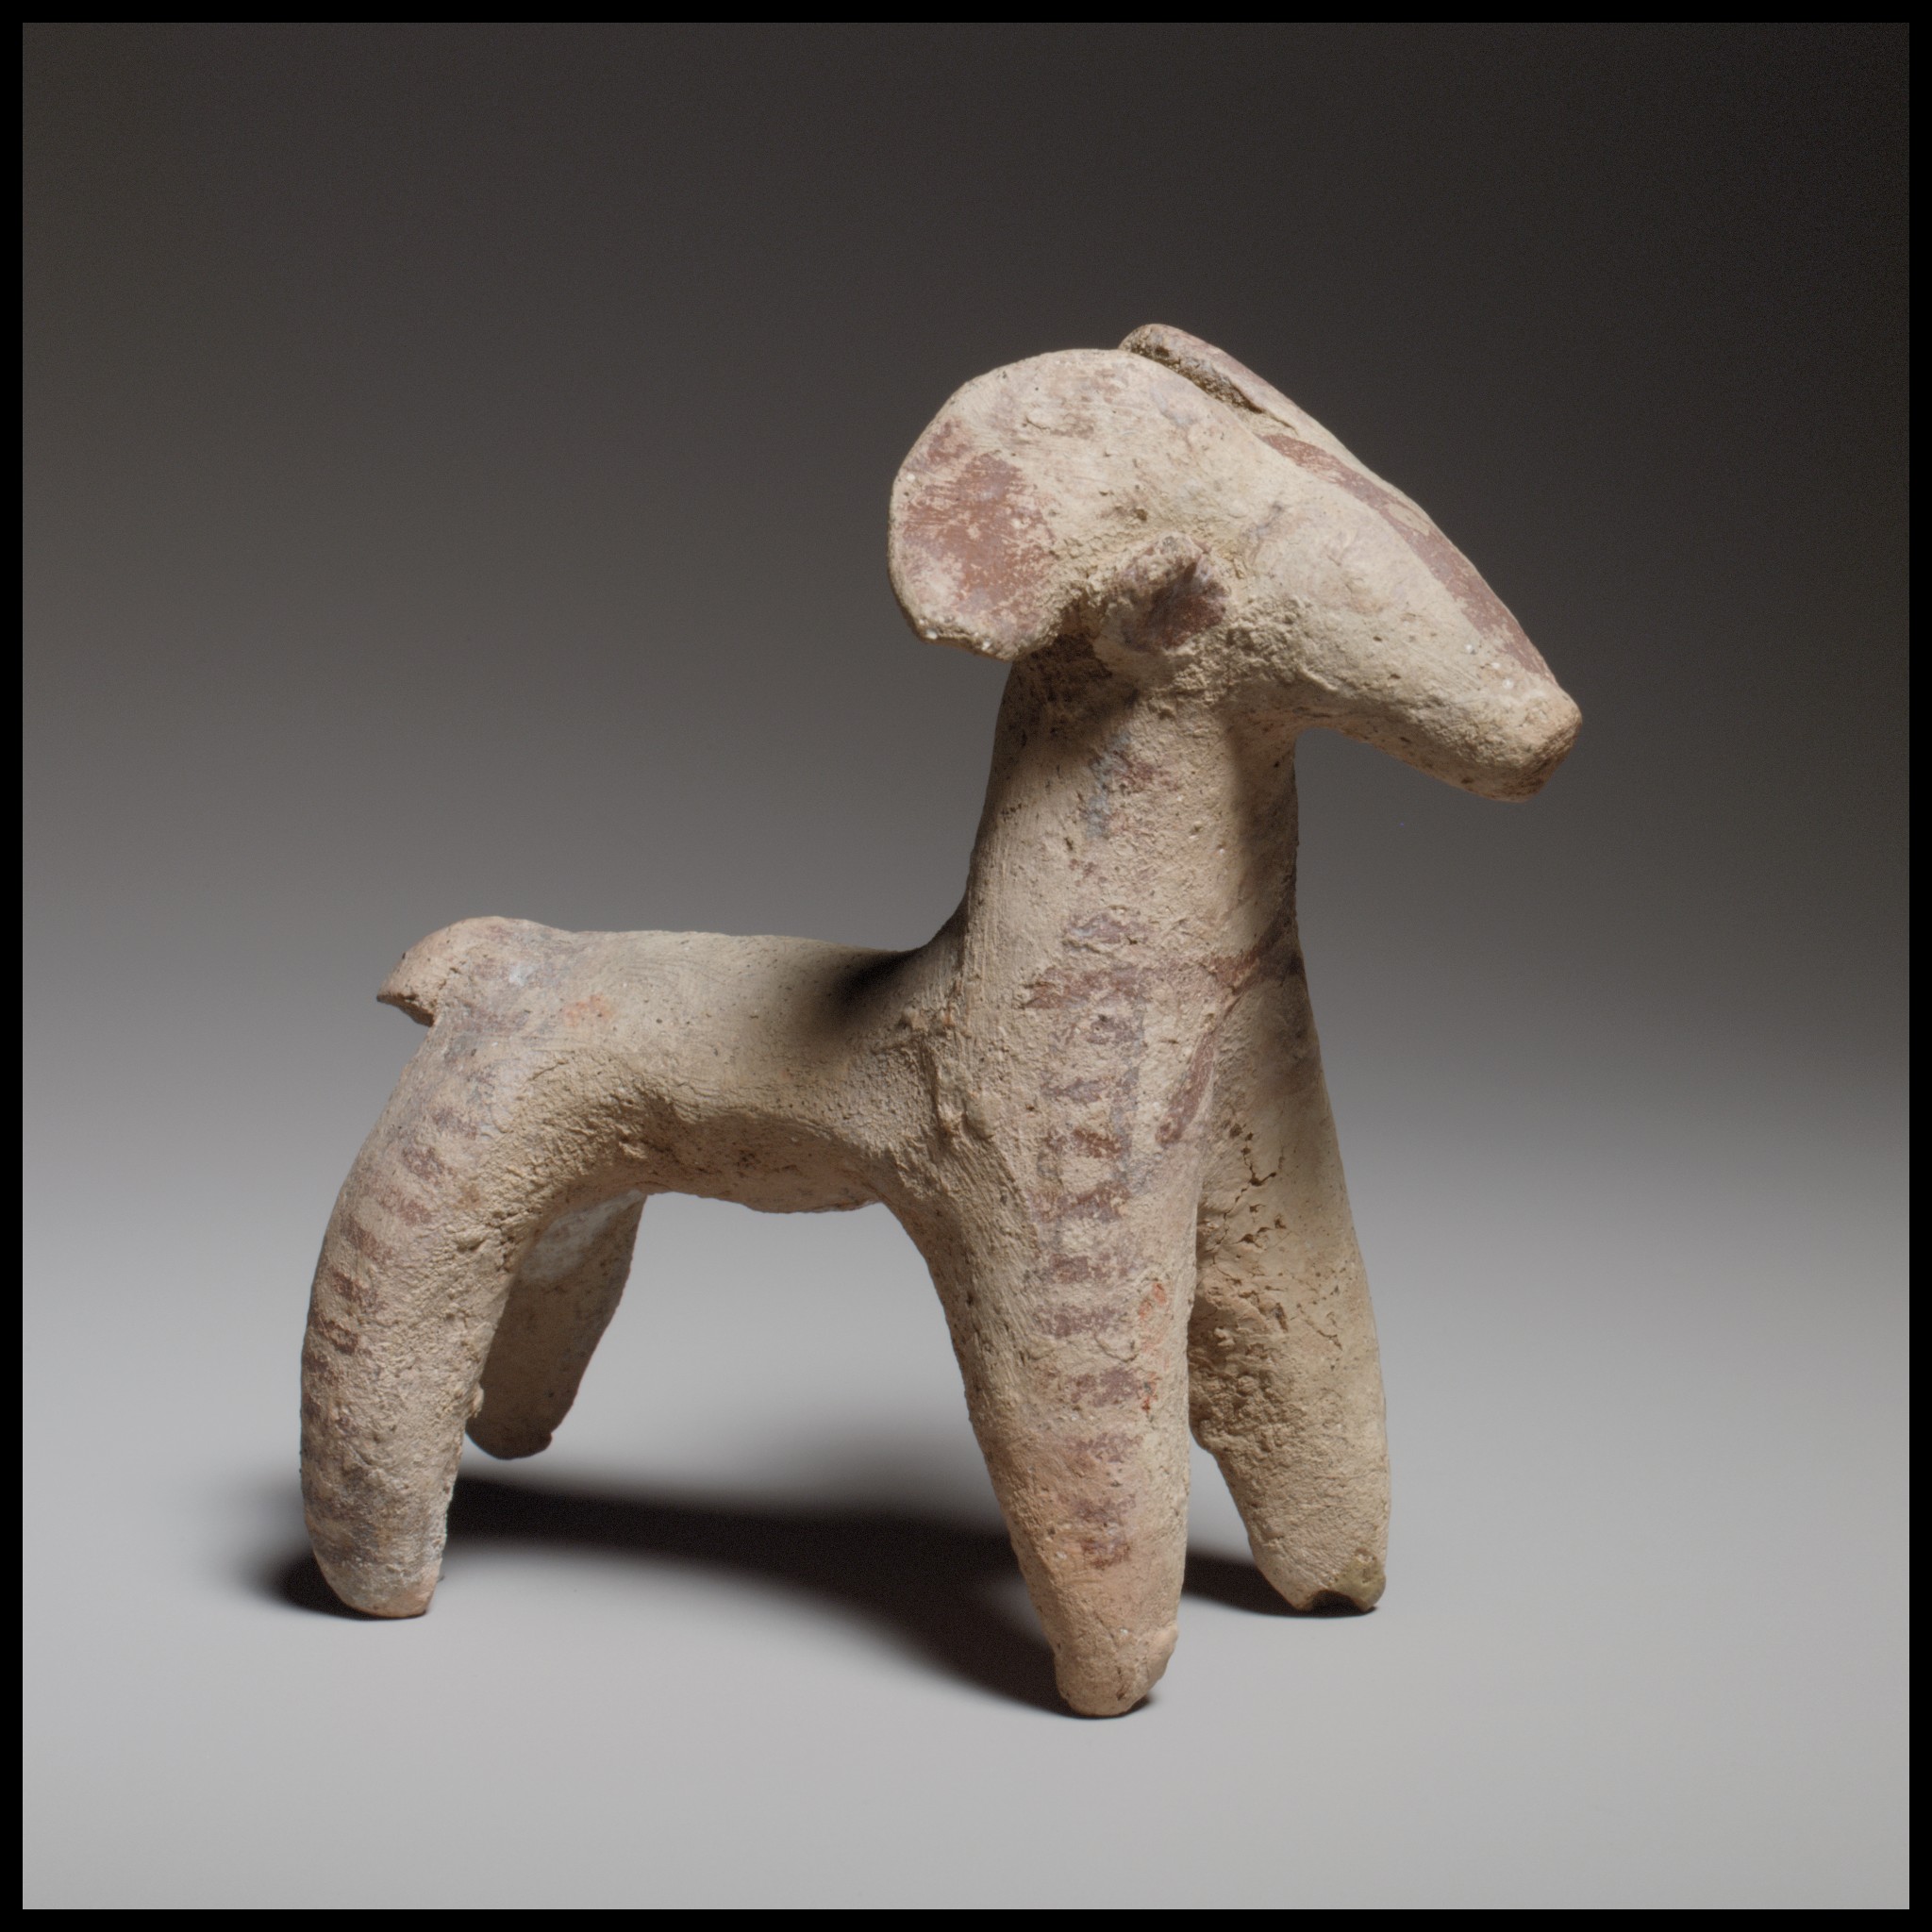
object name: statuette of a ram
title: Ram figurine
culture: cypriot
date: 600-480 BCE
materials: terracotta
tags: rams